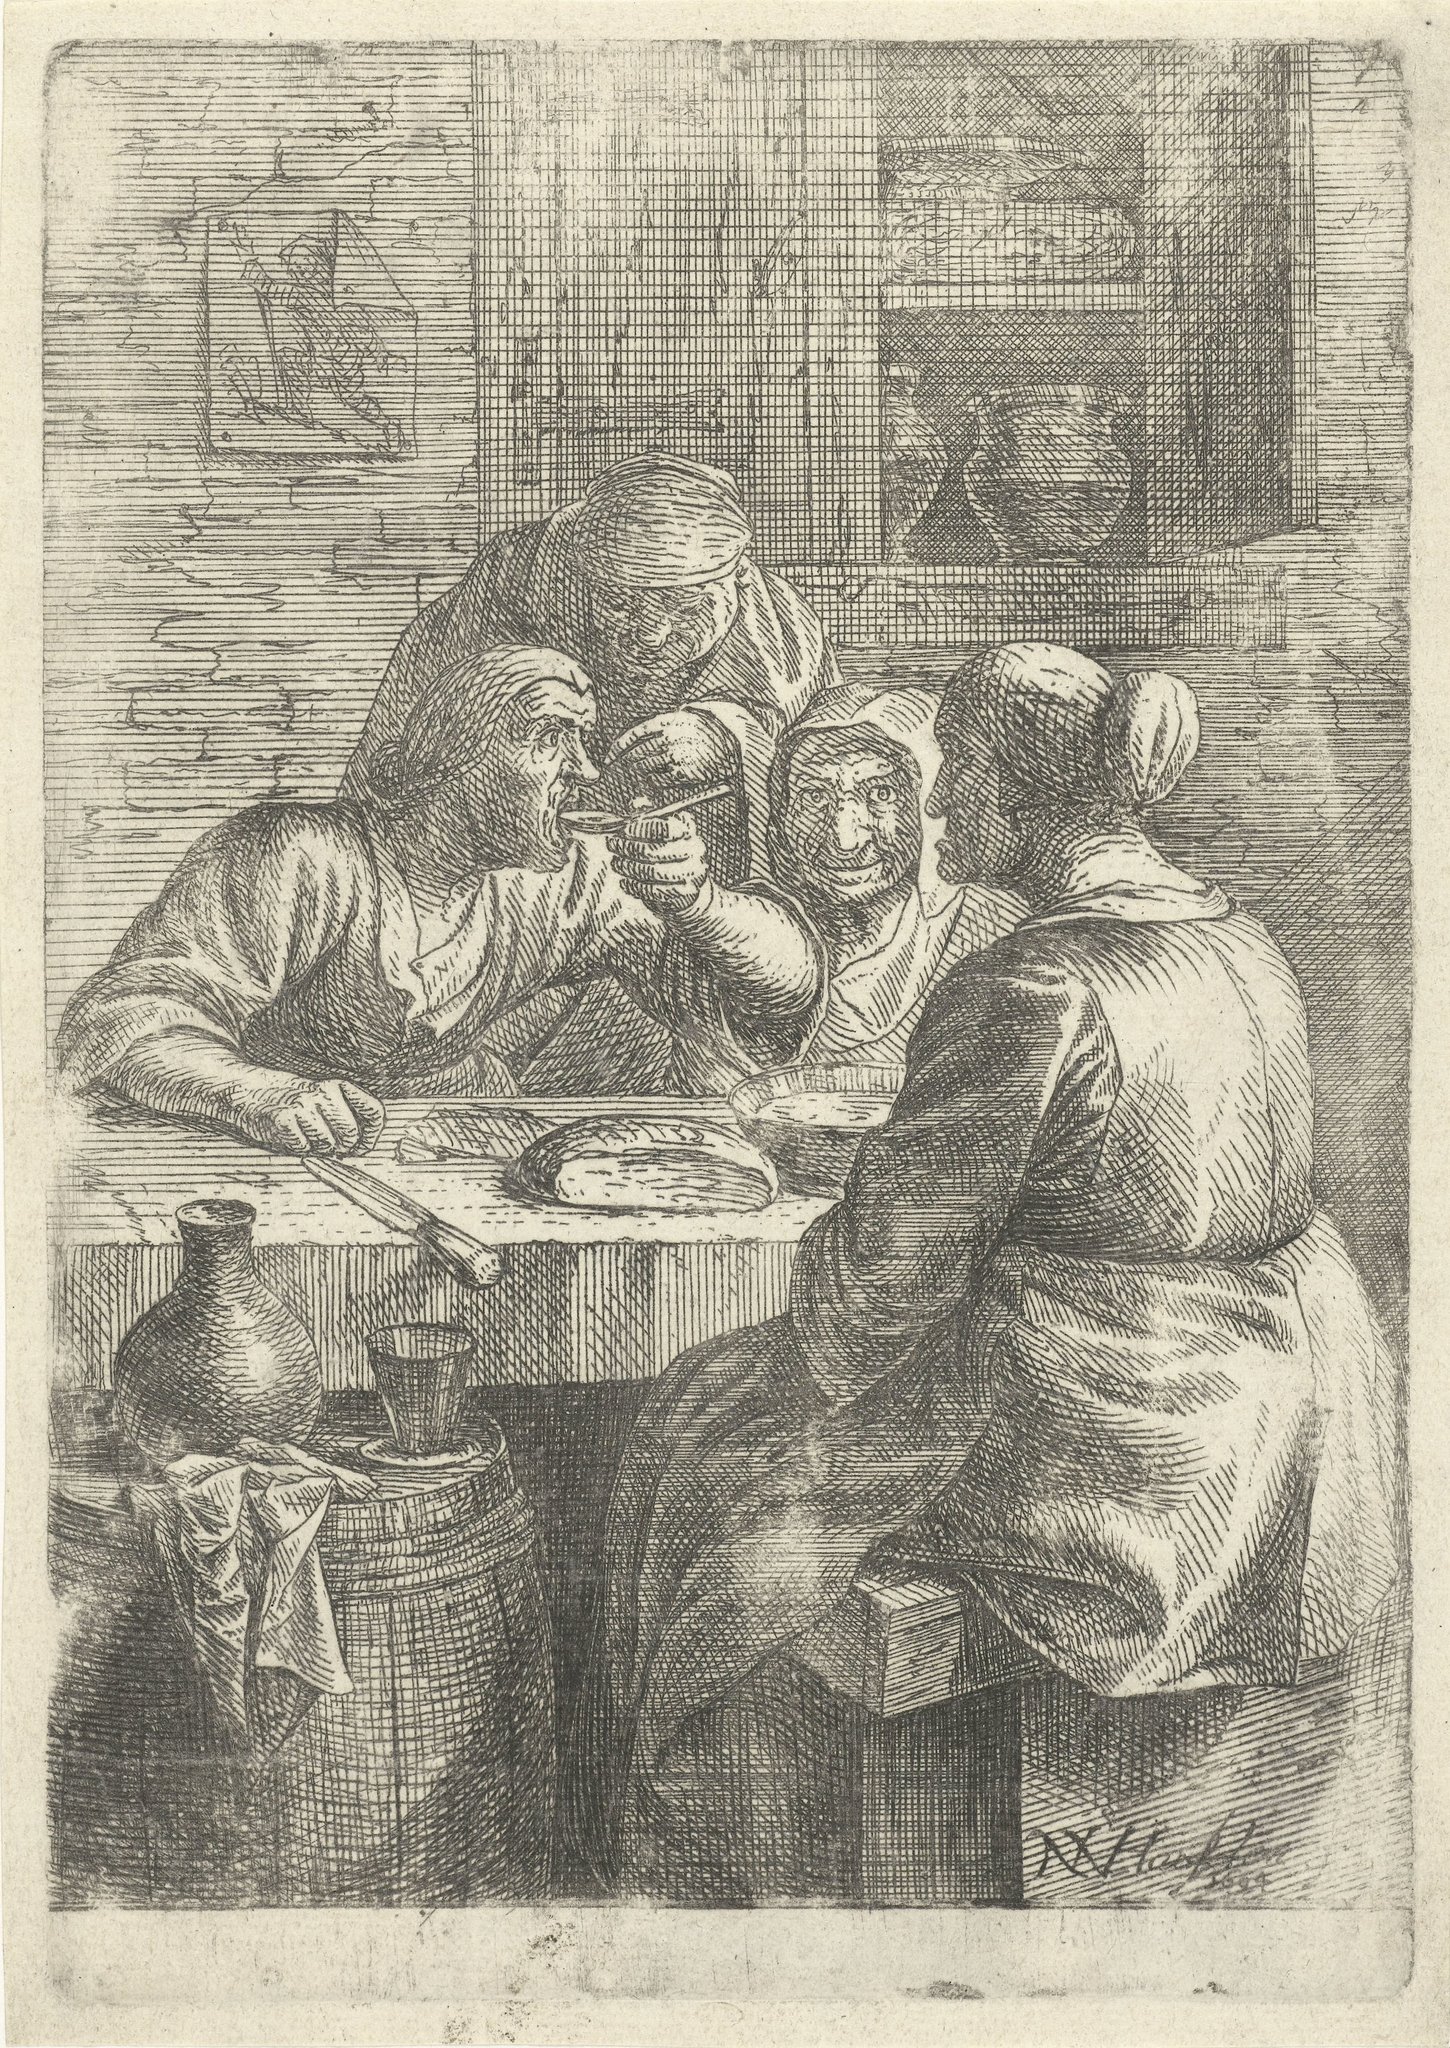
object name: print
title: Drie etende oude vrouwen aan een tafel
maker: nicolaes van haeften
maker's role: draughtsman, painter, print maker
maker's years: 1653-1715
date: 1694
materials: paper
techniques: etching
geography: paris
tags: eating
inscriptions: collector's mark: Lugt 2228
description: Drie etende oude vrouwen aan een tafel. Achter hen een staande oude vrouw. Linksvoor een ton waarop een kruik. Aan de muur hangt een prent